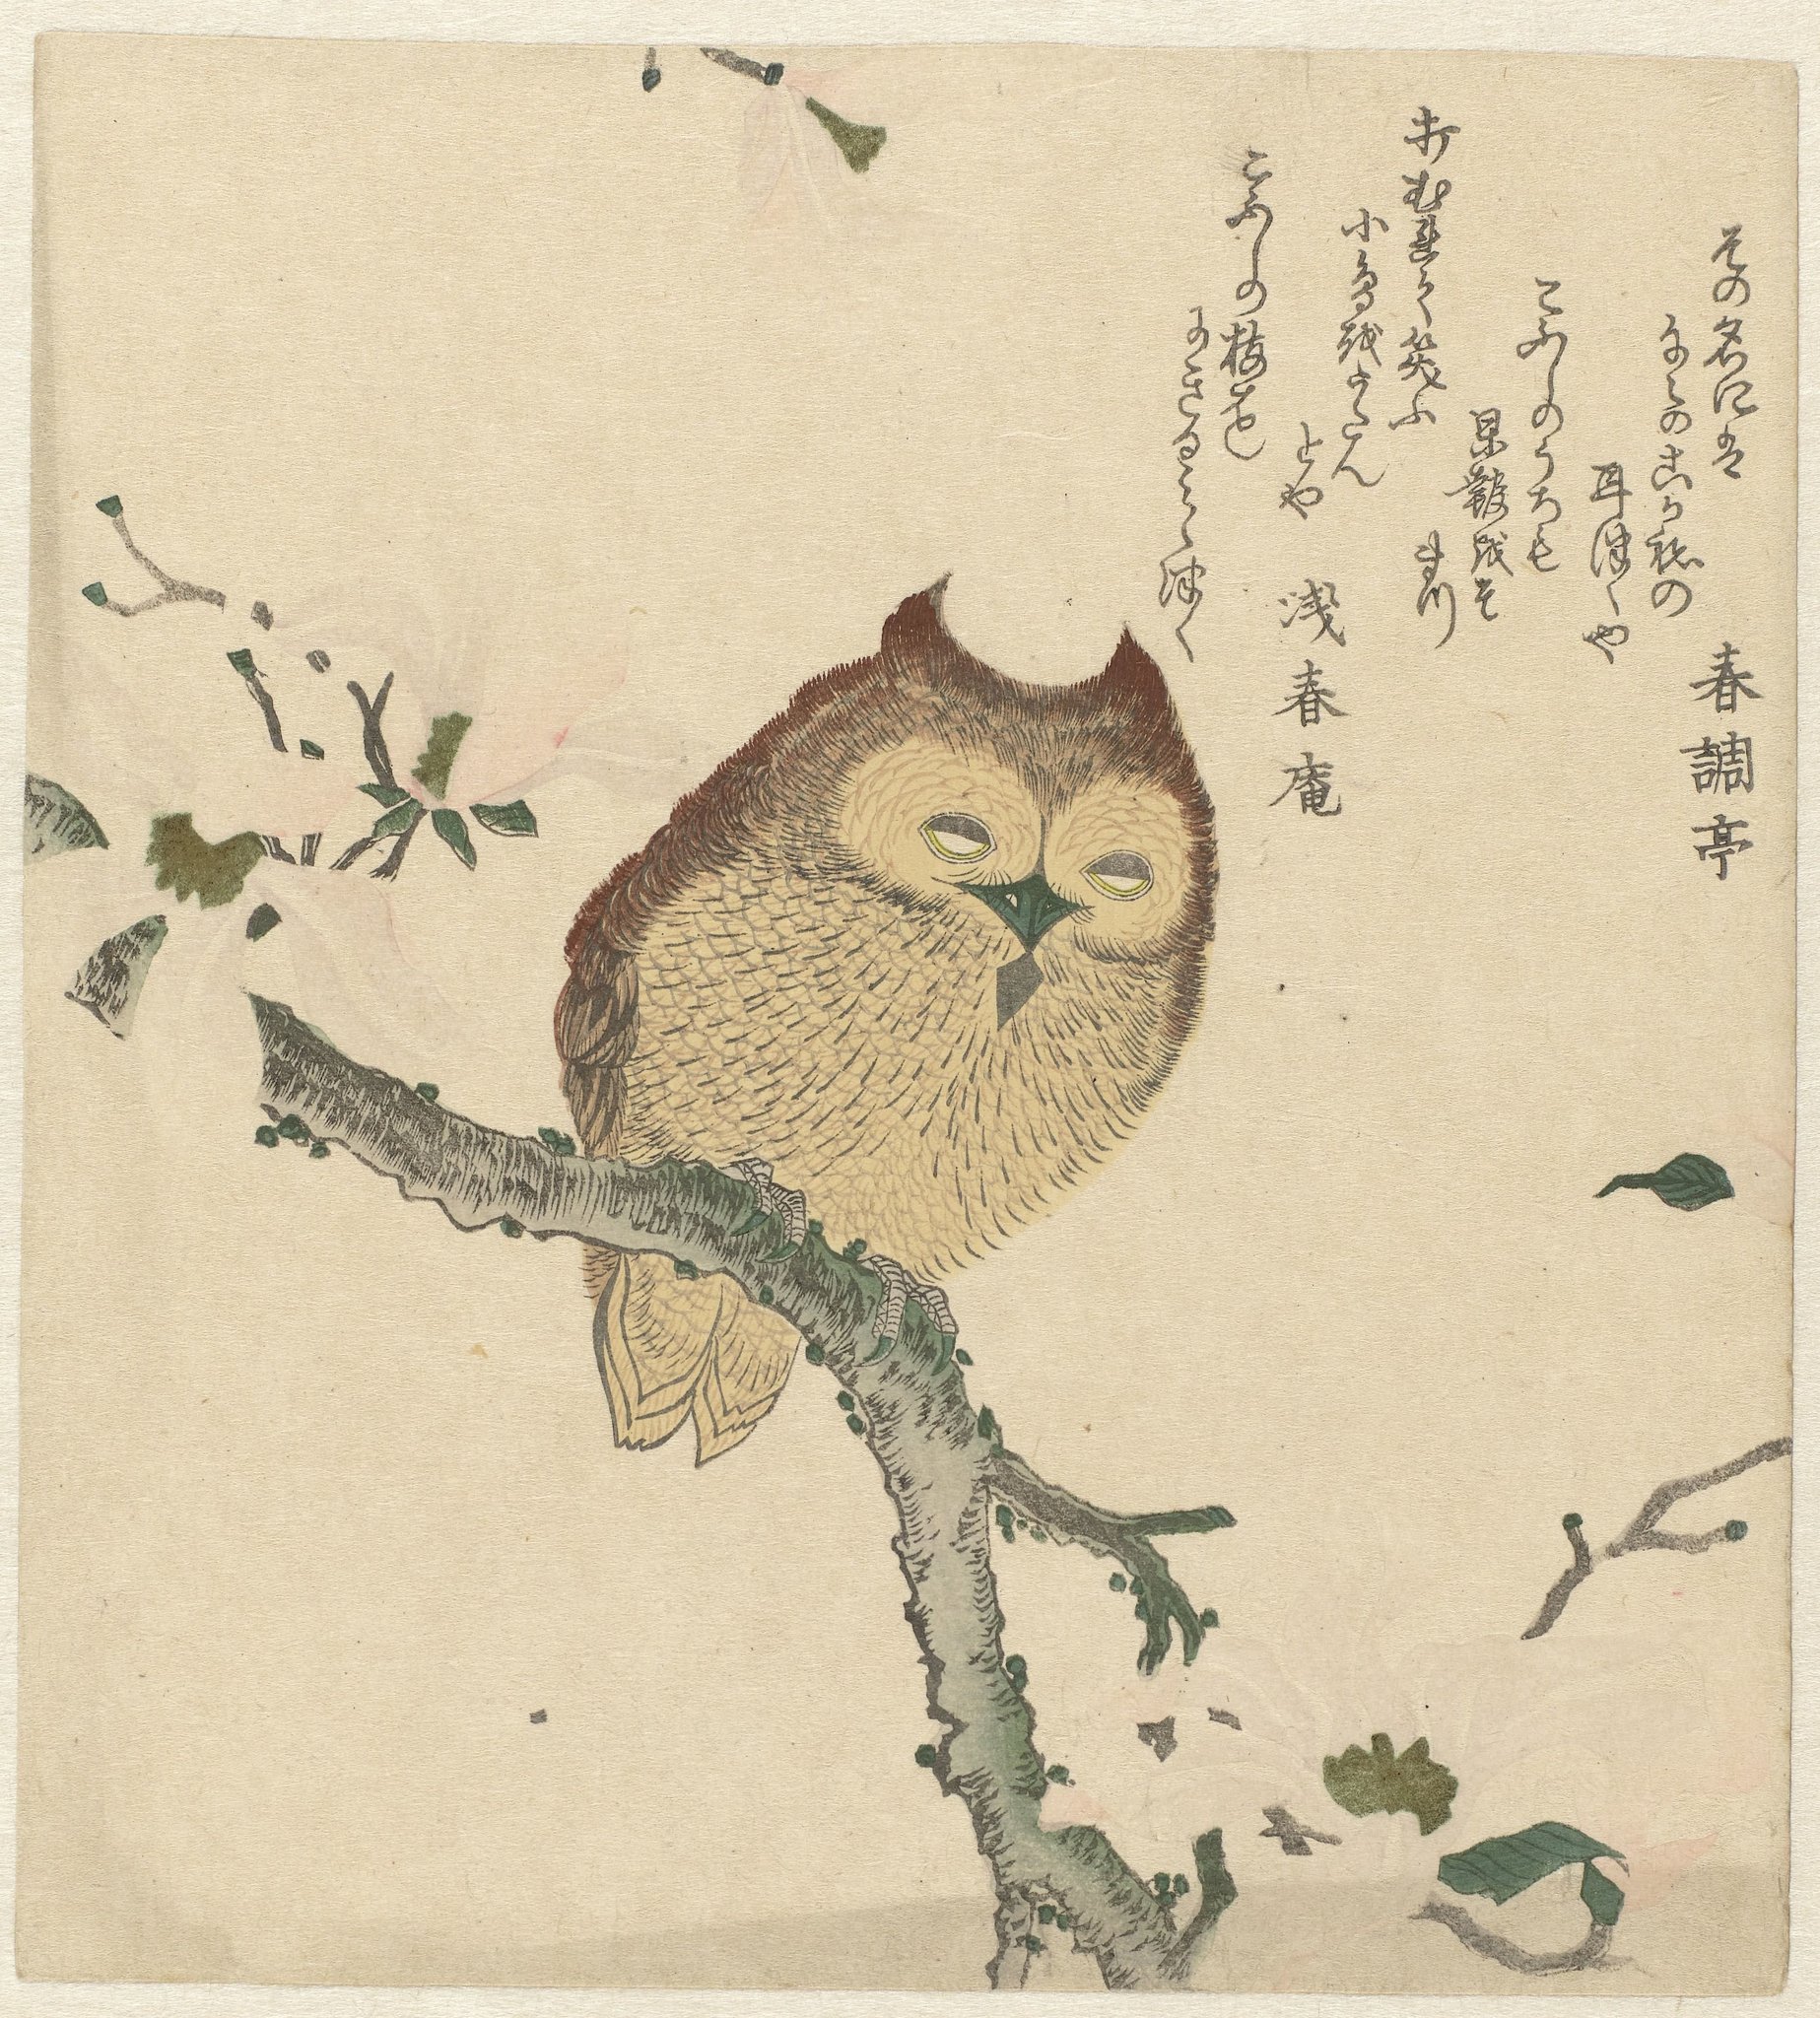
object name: surimono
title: Owl on a Magnolia Branch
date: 1890-1900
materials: paper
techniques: blind stamped, woodcut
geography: japan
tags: owls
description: Een surimono is een luxe uitgevoerde prent waarop beeld met één of meerdere gedichten gecombineerd is. Bij het drukken van een surimono werd vaak gebruik gemaakt van dikker papier, blinddruk en metaal pigmenten, zoals koper- en zilverpoeder. De prenten werden vaak in opdracht van dichters gemaakt en als exclusief geschenk aan vrienden en relaties gegeven.